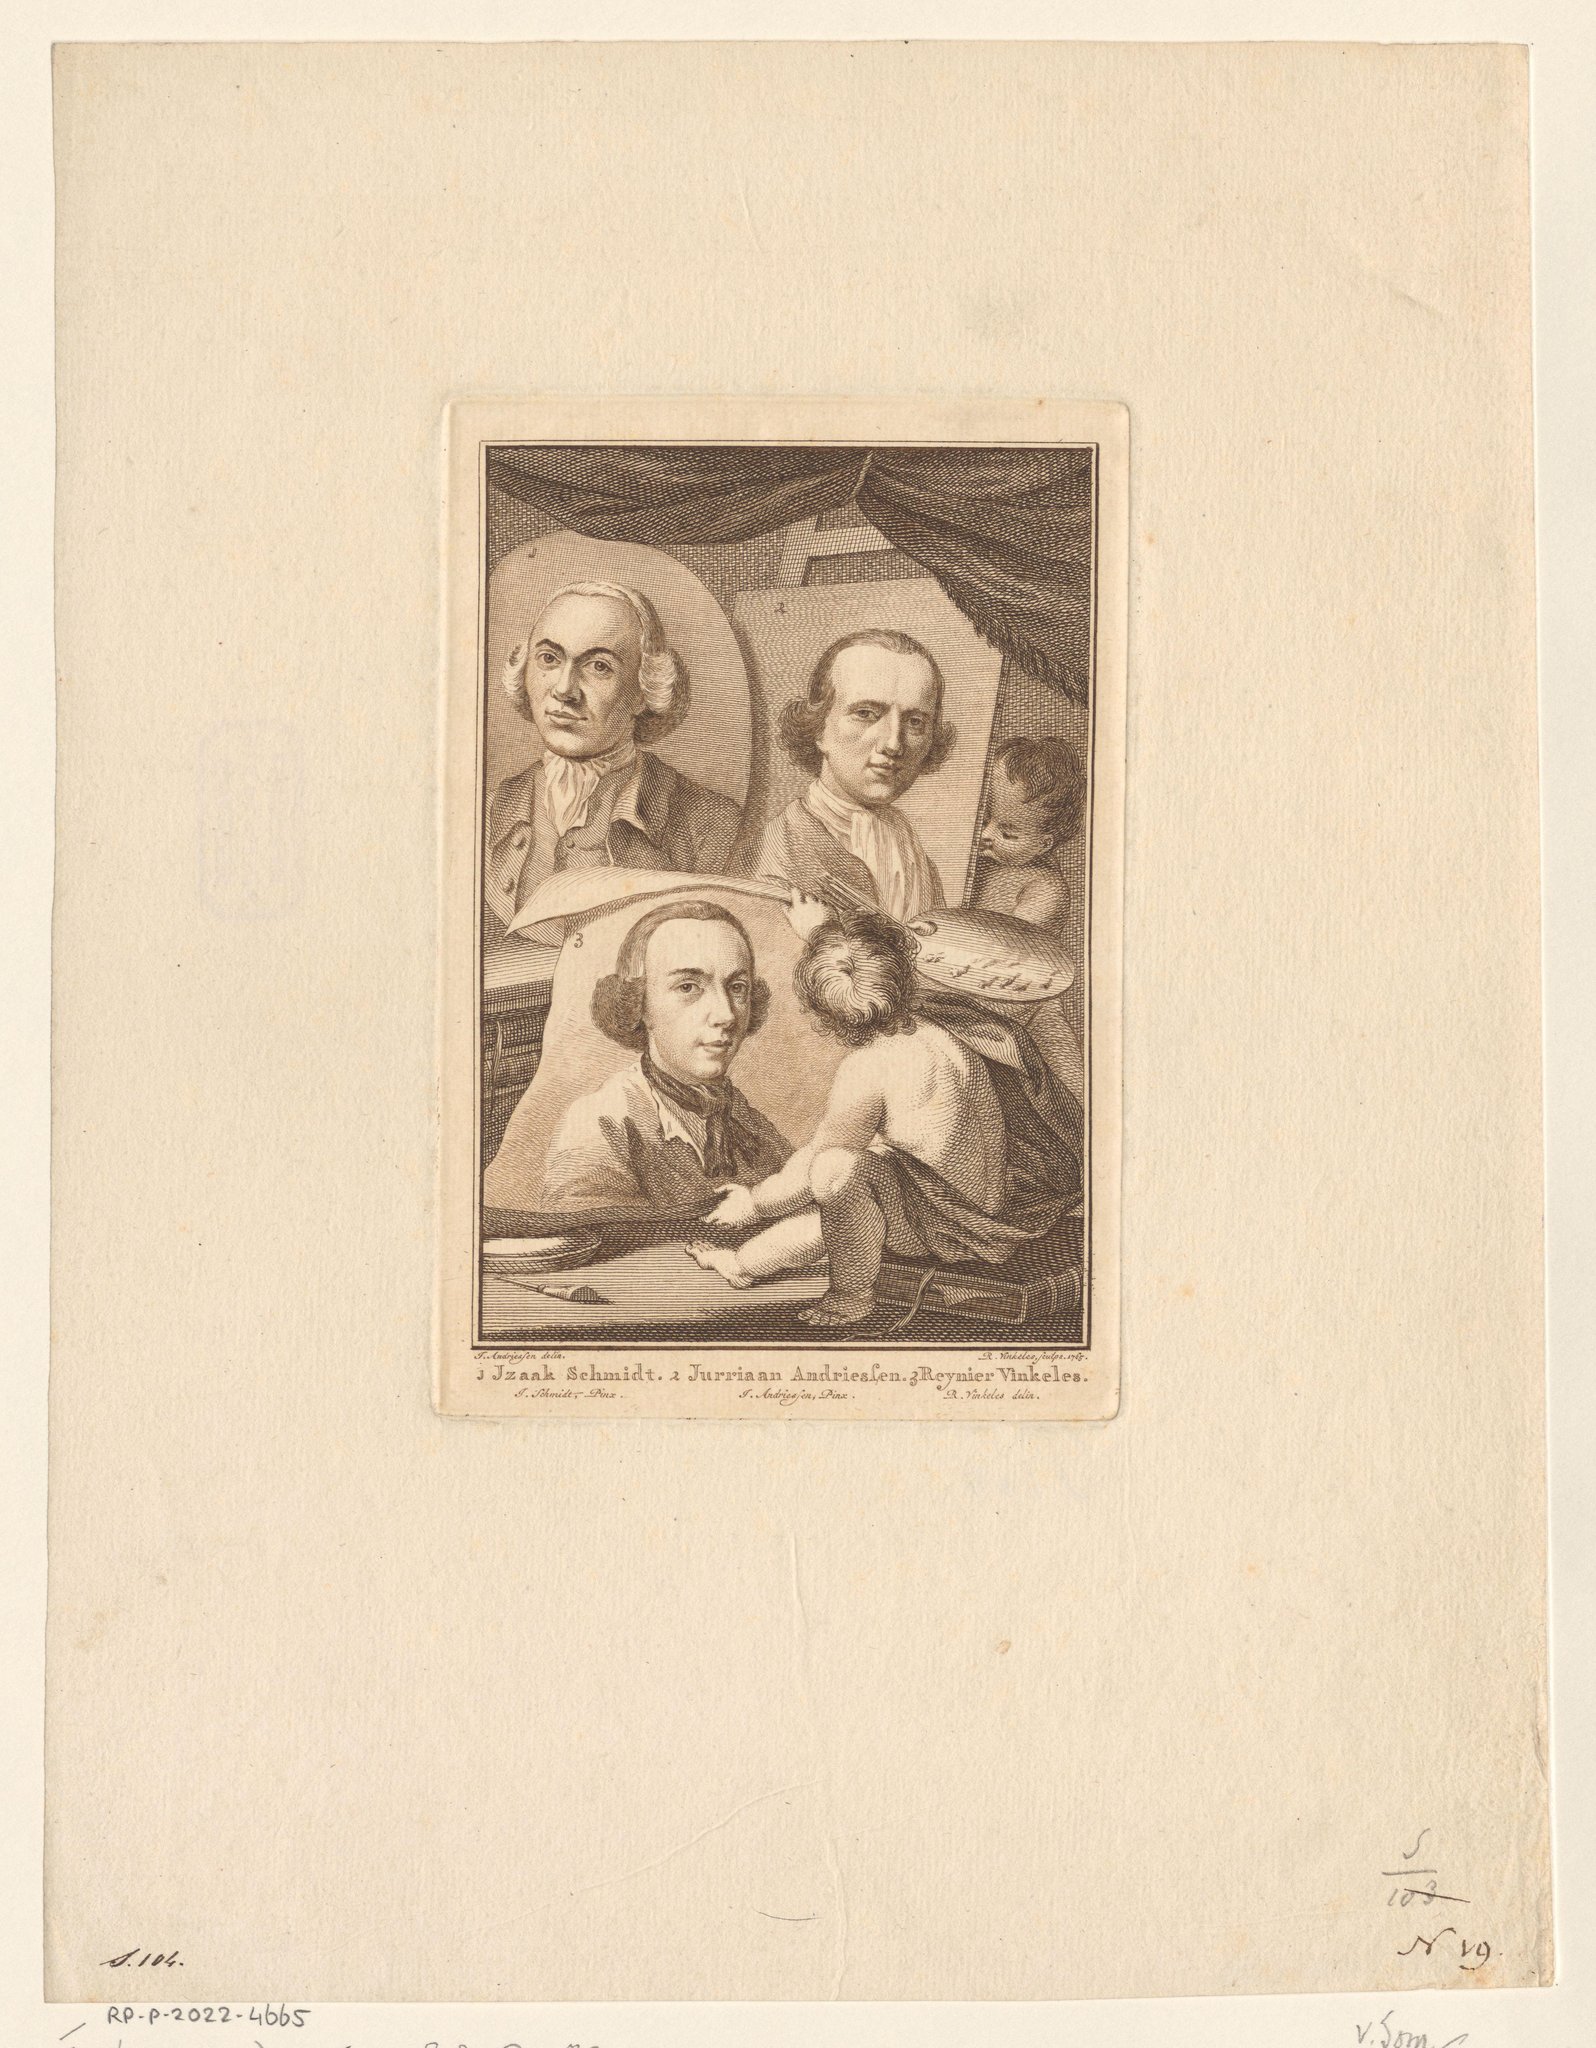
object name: print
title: Portretten van Izaak Schmidt, Jurriaan Andriessen en Reinier Vinkeles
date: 1765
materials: paper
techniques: engraving, etching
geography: amsterdam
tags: painter, jurriaan andriessen, amsterdam, print maker, draughtsman, izaak schmidt, reinier vinkeles (i), drawing, historical persons, portrait, self-portrait of painter, tools, implements of painter, cupids: 'amores', 'amoretti', 'putti', portrait, self-portrait of graphic artist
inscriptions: collector's mark: Lugt 11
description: Onderaan handgeschreven genummerd: s.104, en: N 19.